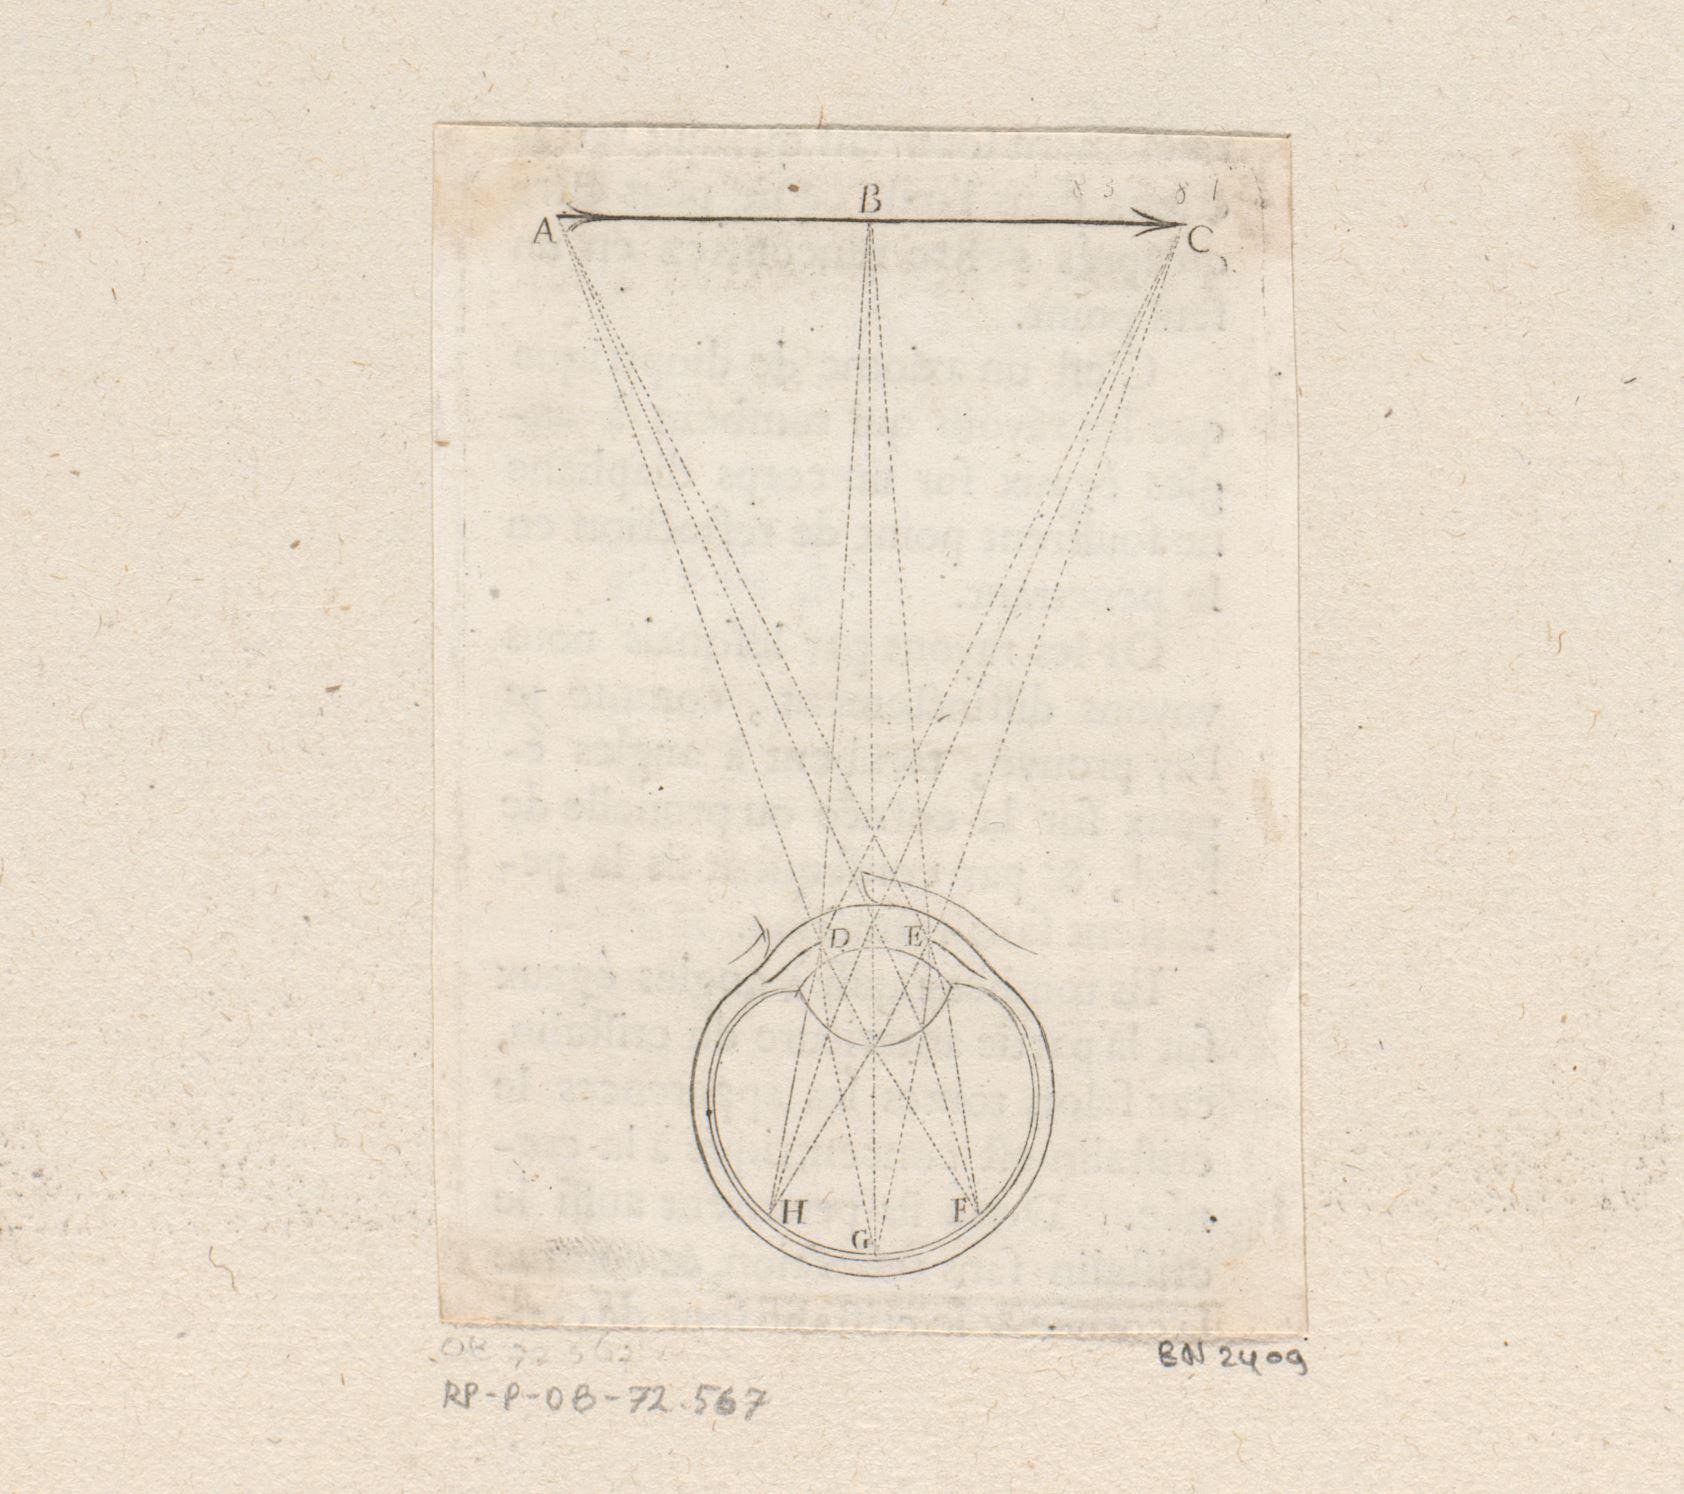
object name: book illustration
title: Weergave van pijl op retina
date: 1679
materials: paper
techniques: etching, letterpress printing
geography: paris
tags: optics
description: Prent uit: Leclerc, Sébastien. Discours touchant le point de veue, dans lequel il est prouvé que les choses qu'on voit (...). Parijs: Thomas Jolly, 1679.